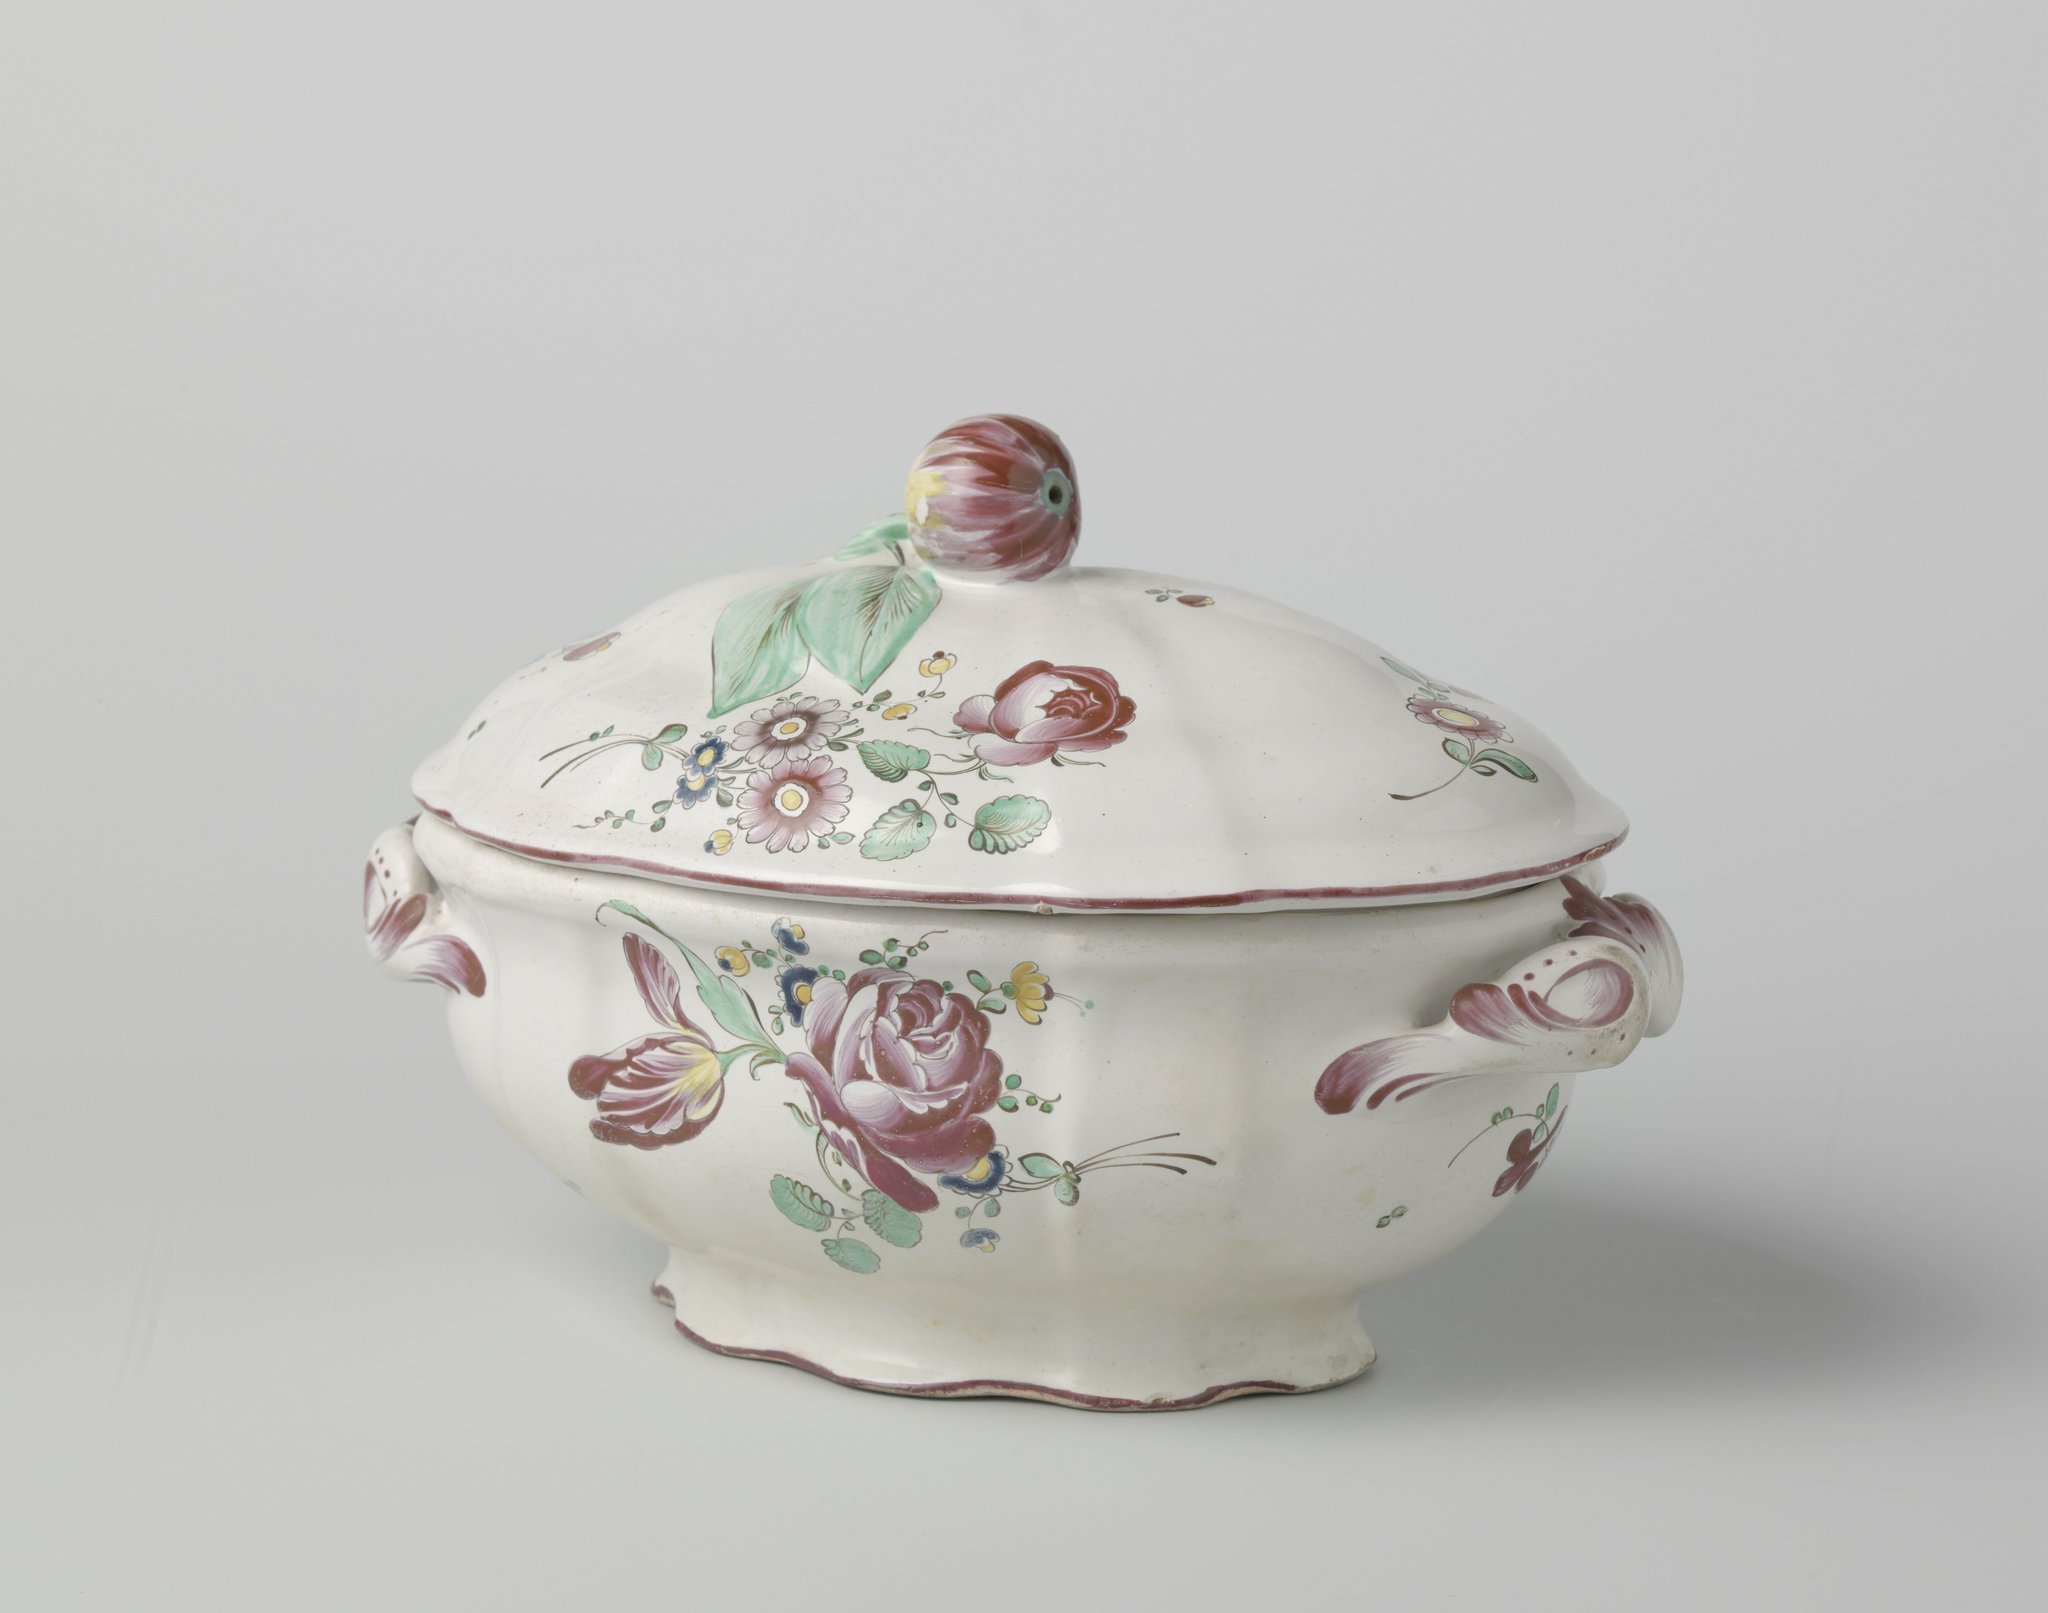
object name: soup tureen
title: Soepterrine met deksel van aardewerk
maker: Anonymous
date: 1740-1760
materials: earthenware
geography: straatsburg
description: Soepterrine met deksel van aardewerk. De ovale terrine met gewelfde wand en lage gegolfde voet is versierd met twee bouquetten, waarvan één is samengesteld uit een paarse tulp, een paarse roos en een tak blauwe en gele bloemen en groene bladeren en de andere uit een roos, twee asters en een takje gele en blauwe bloemen. In de lengte-as in rocaille, vormen twee oren met paarsachtige bladeren. Het gewelfde en gegolfde deksel heeft een overeenkomstig decor en is bekroond door een paarse en gele vrucht aan een steel met lichtgroene bladeren. Het glazuur is enigszins kalkachtig. Geen merken.